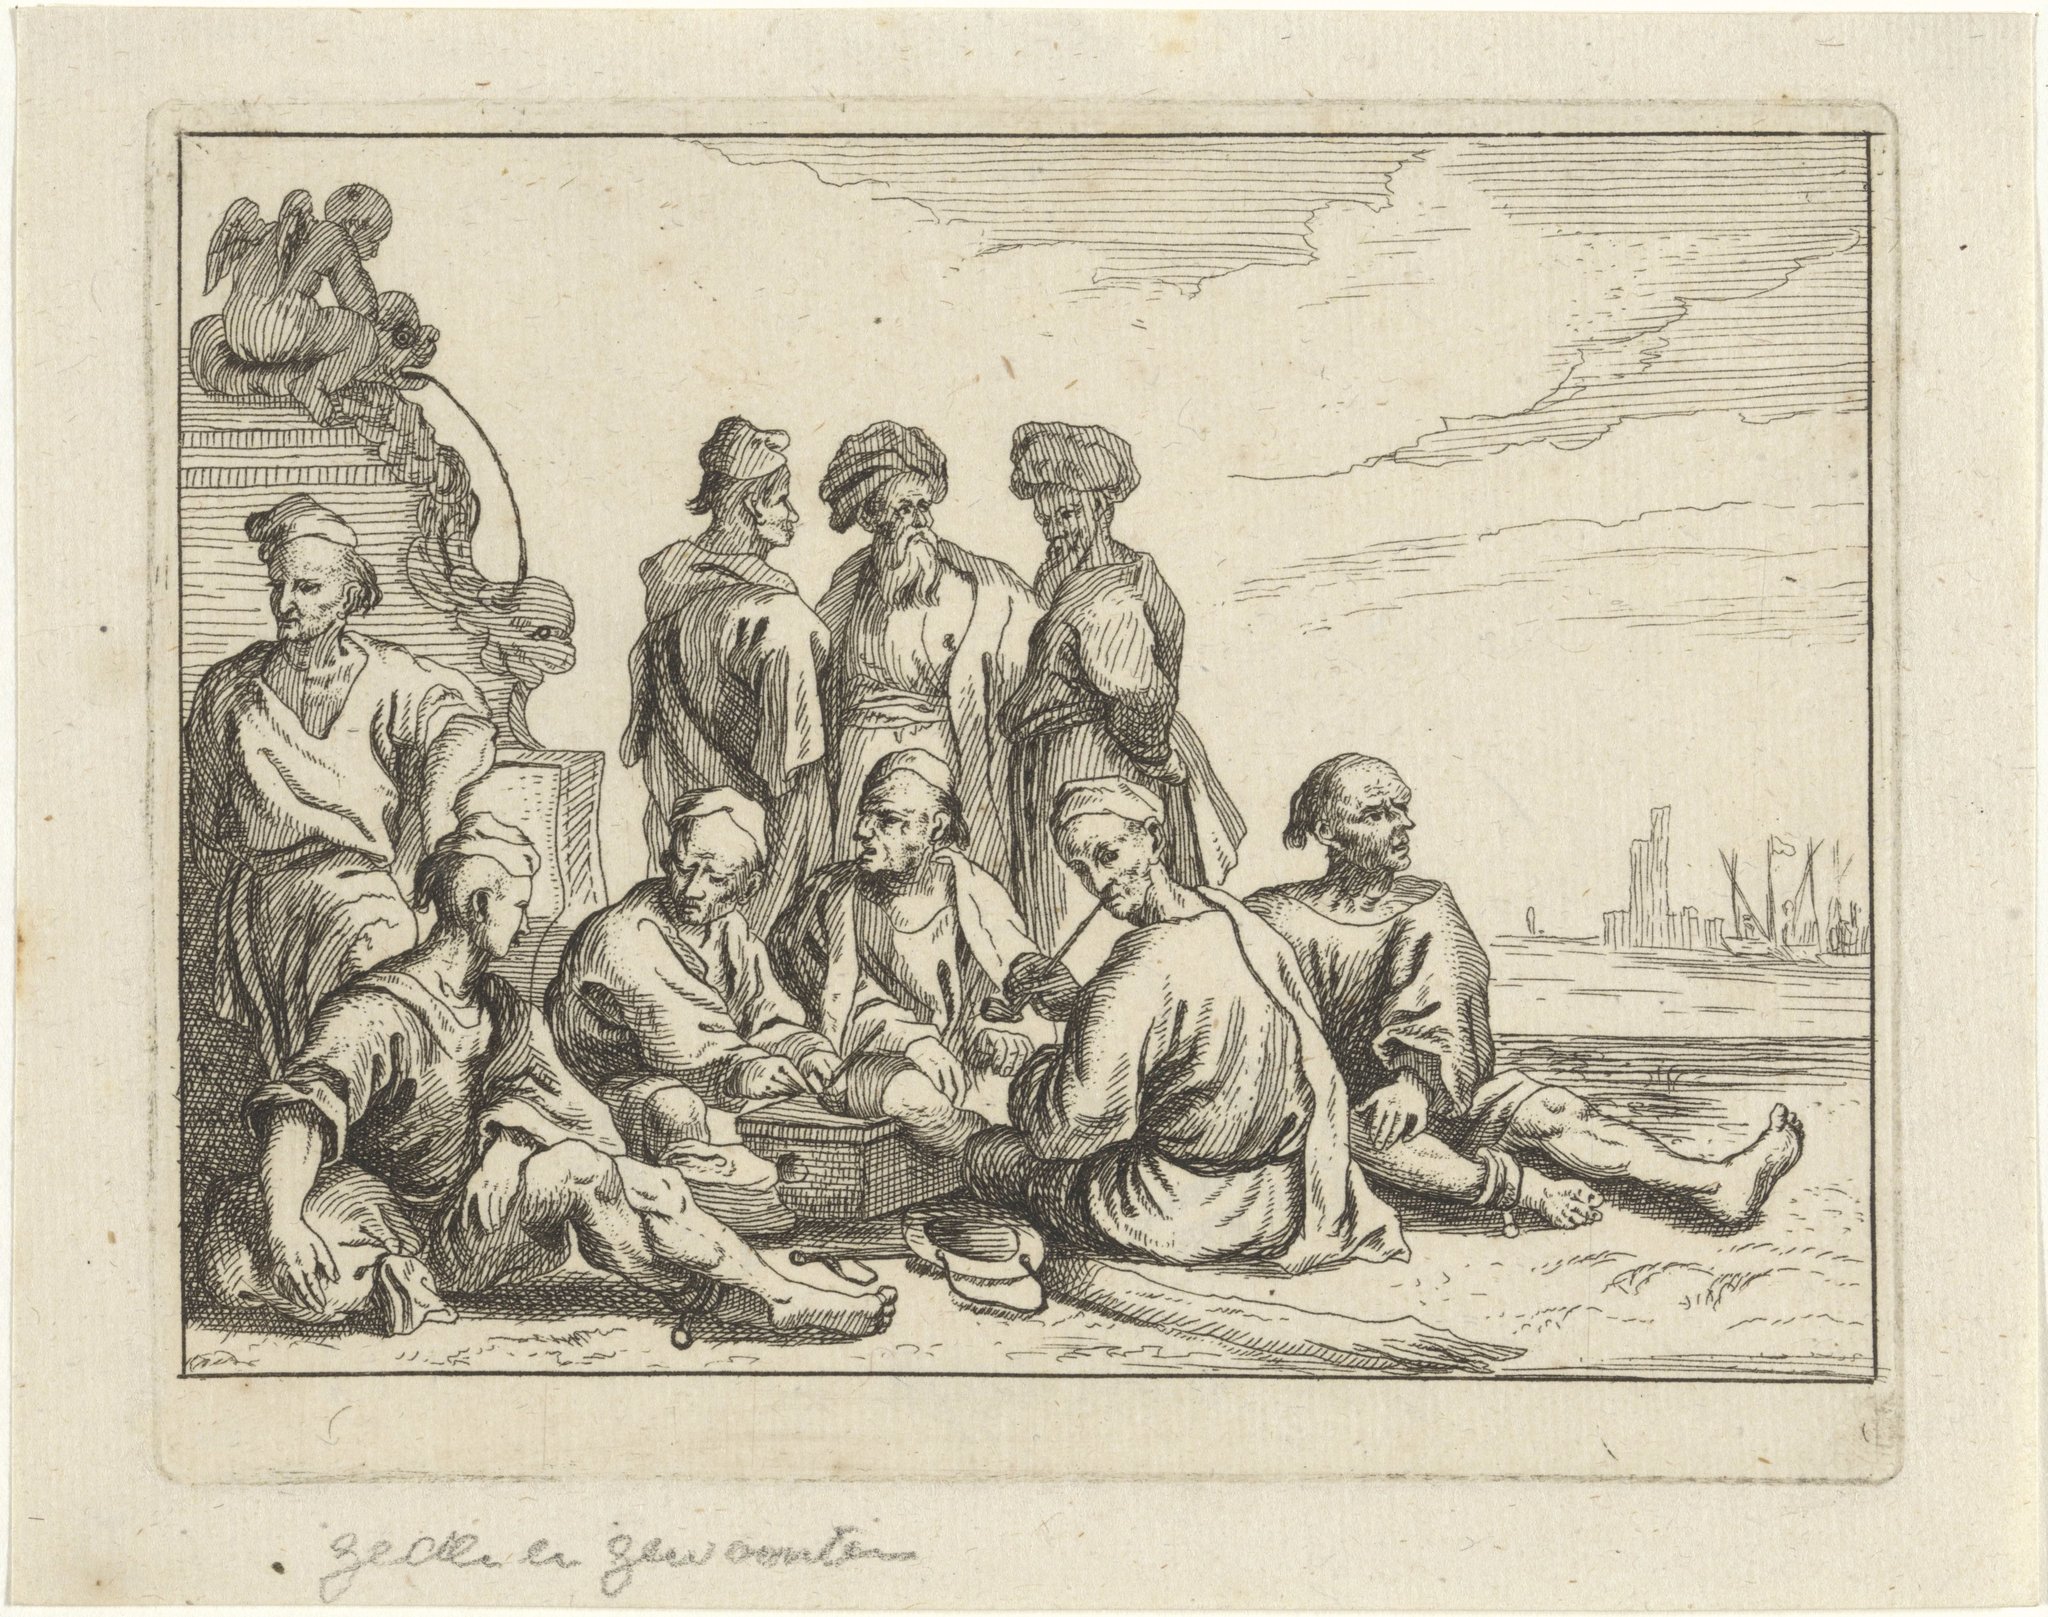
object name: print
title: Haventaferelen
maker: m. schaep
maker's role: print maker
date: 1649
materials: paper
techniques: etching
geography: genoa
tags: harbour, slavery; serfs and enslaved persons, ornamental fountain, seaman: sailor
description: Islamitische galeislaven rusten bij een fontein. Eén van hen rookt een pijp. Deze tot slaaf gemaakte mannen zijn als moslims te herkennen door het typerende kapsel (hoofd op een pluk na kaalgeschoren) dat zij verplicht waren te hebben. De staande mannen met tulband zijn waarschijnlijk papassi (moellahs en vertegenwoordigers van de islamitische tot slaaf gemaakten). Rechtssachter enkele schepen in het water.